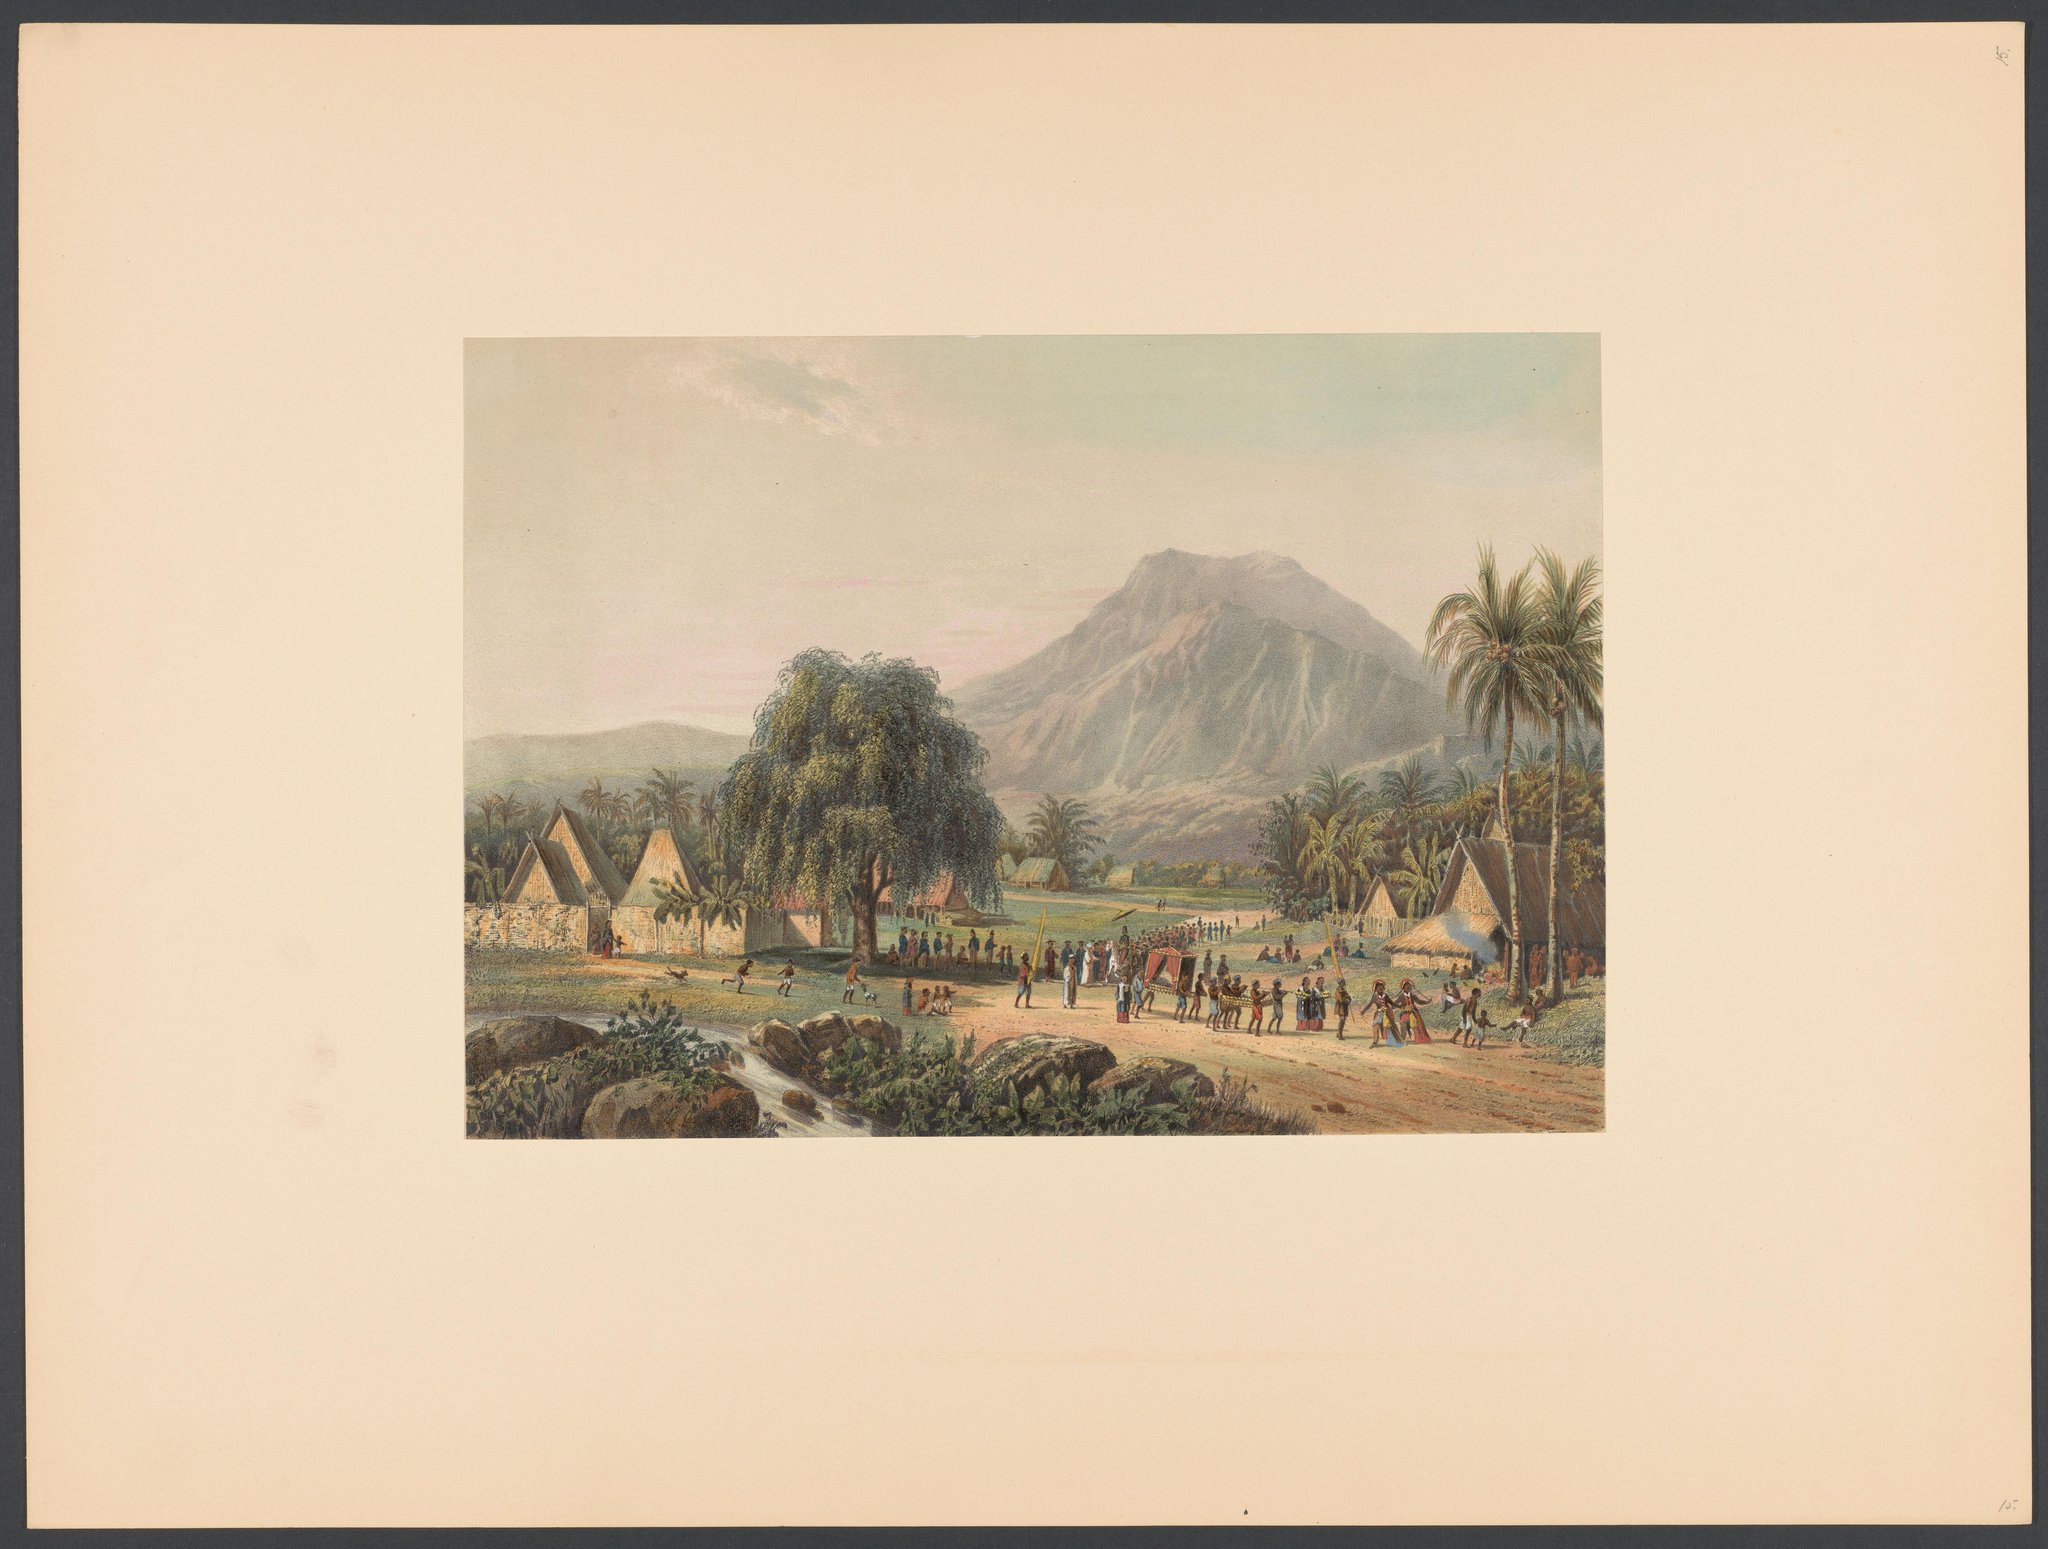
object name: print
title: Huwelijksceremonie aan de voet van de Salak berg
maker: johan conrad greive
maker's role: draughtsman, painter, print maker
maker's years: 1837-1891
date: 1865-1872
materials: paper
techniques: lithograph, hand coloring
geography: amsterdam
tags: wedding feast, wedding meal, landscapes with waters, waterscapes, seascapes (in the temperate zone), mountains, java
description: Volgens de bijbehorende inhoudsopgave betreft dit de 15de prent uit de reeks van 24.